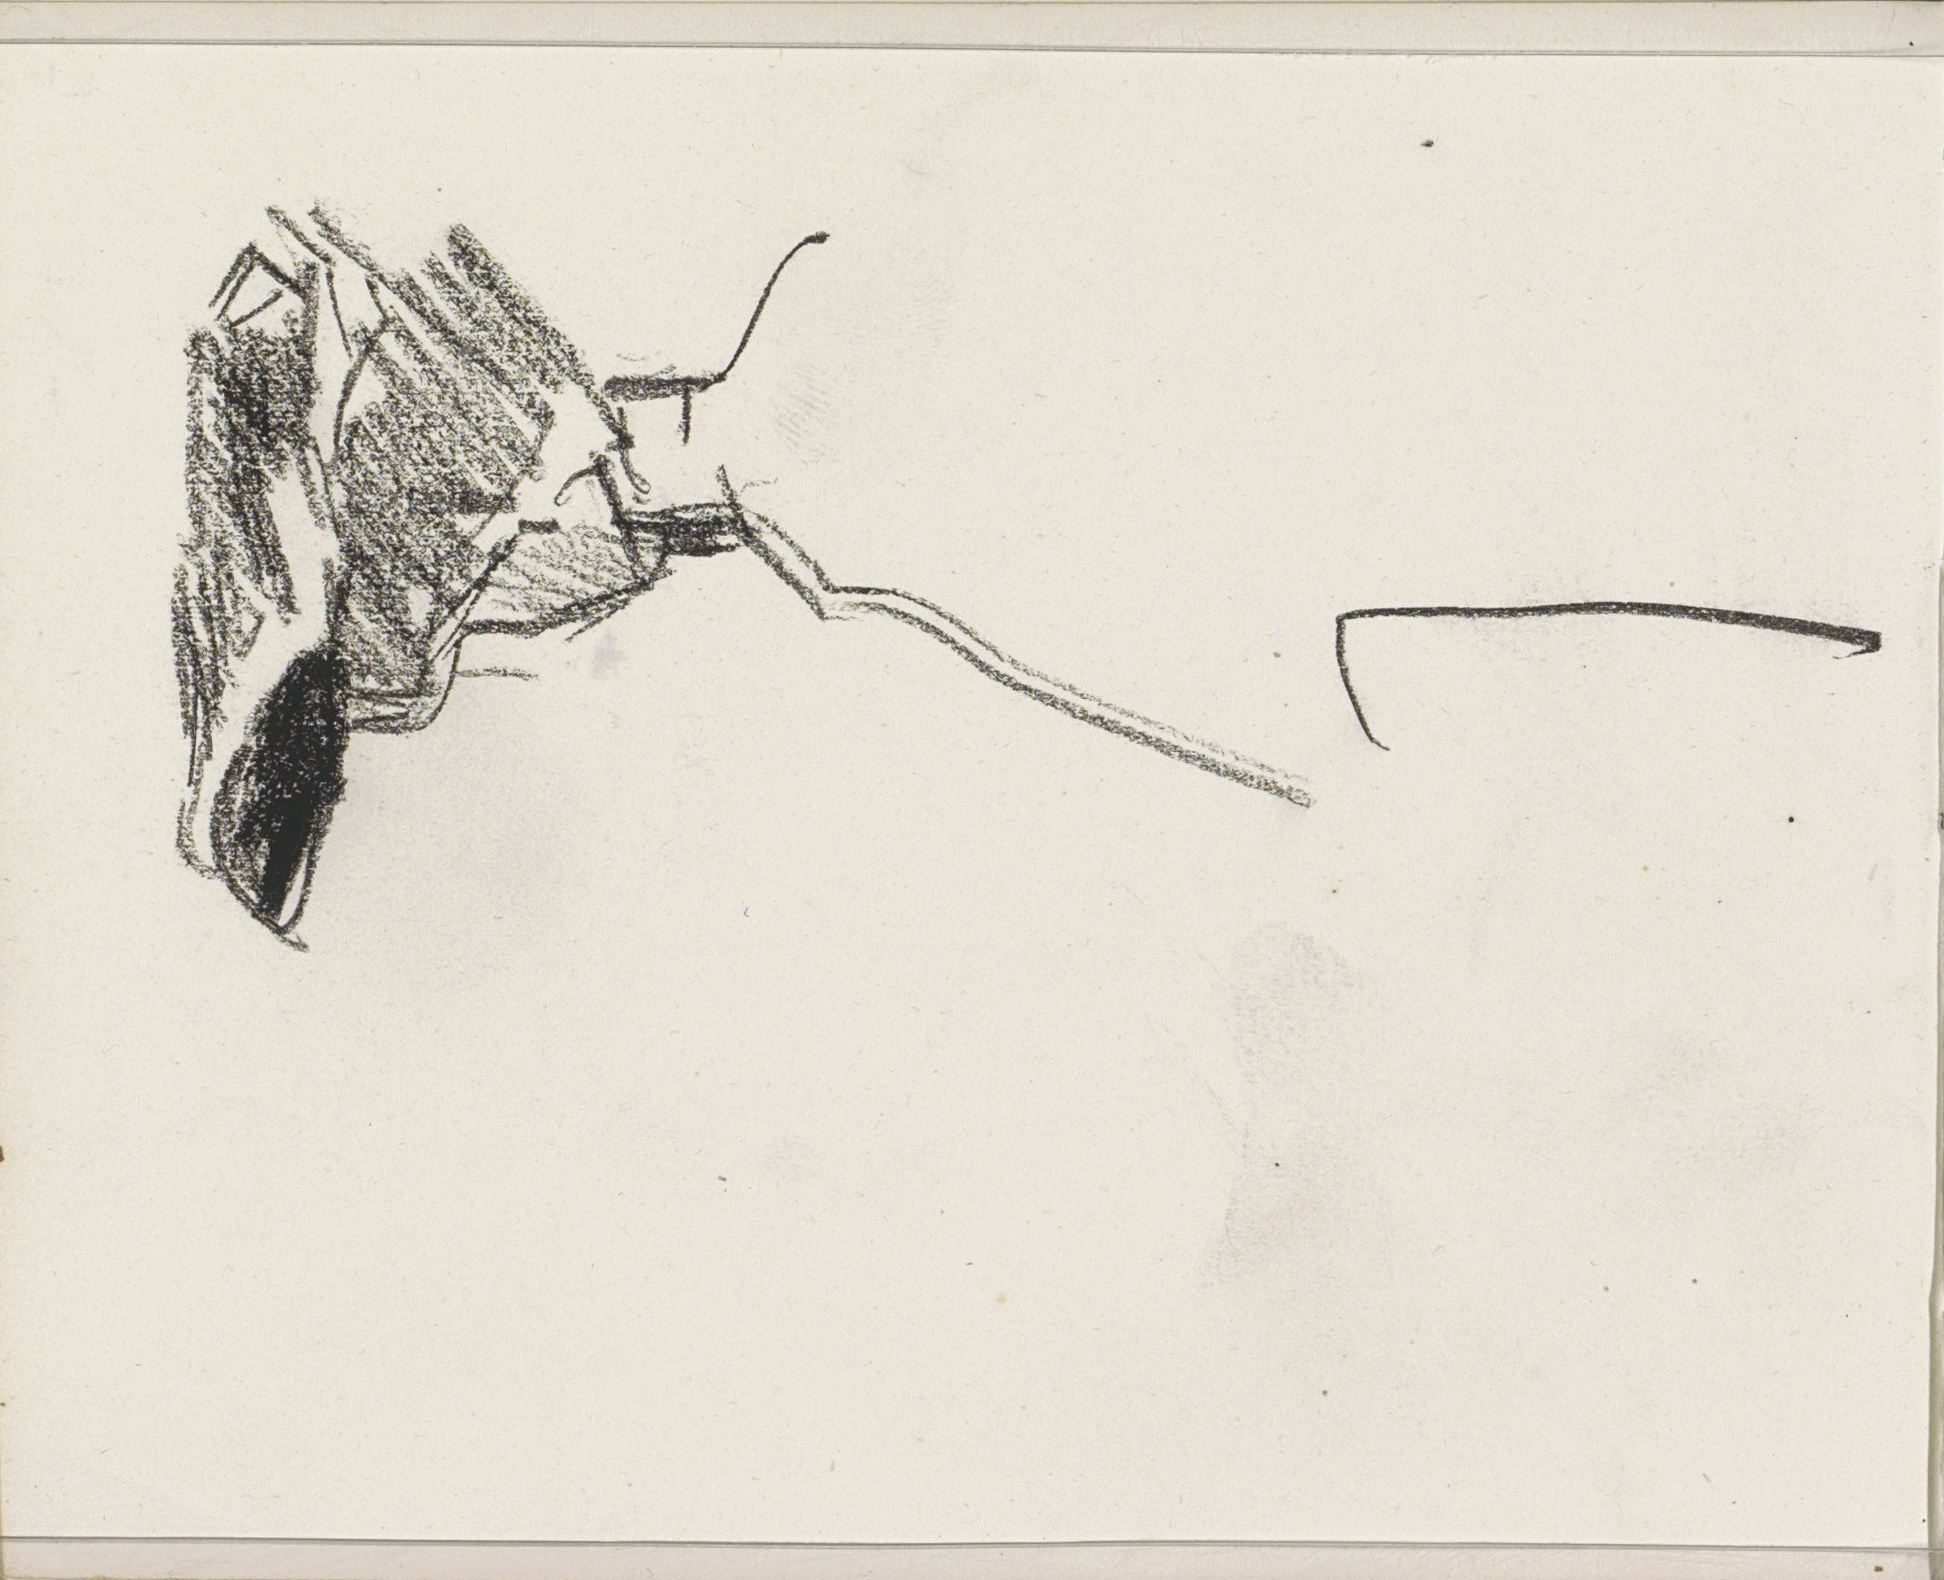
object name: sketchbook leaf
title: Vrouw met hoed, op de rug gezien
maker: isaac israels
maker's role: draughtsman, painter, print maker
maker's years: 1865-1934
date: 1875-1934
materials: chalk, paper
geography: the hague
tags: adult woman (+ back view), head-gear: hat (+ women's clothes)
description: Pagina 45 uit schetsboek XLIII met 61 pagina's.